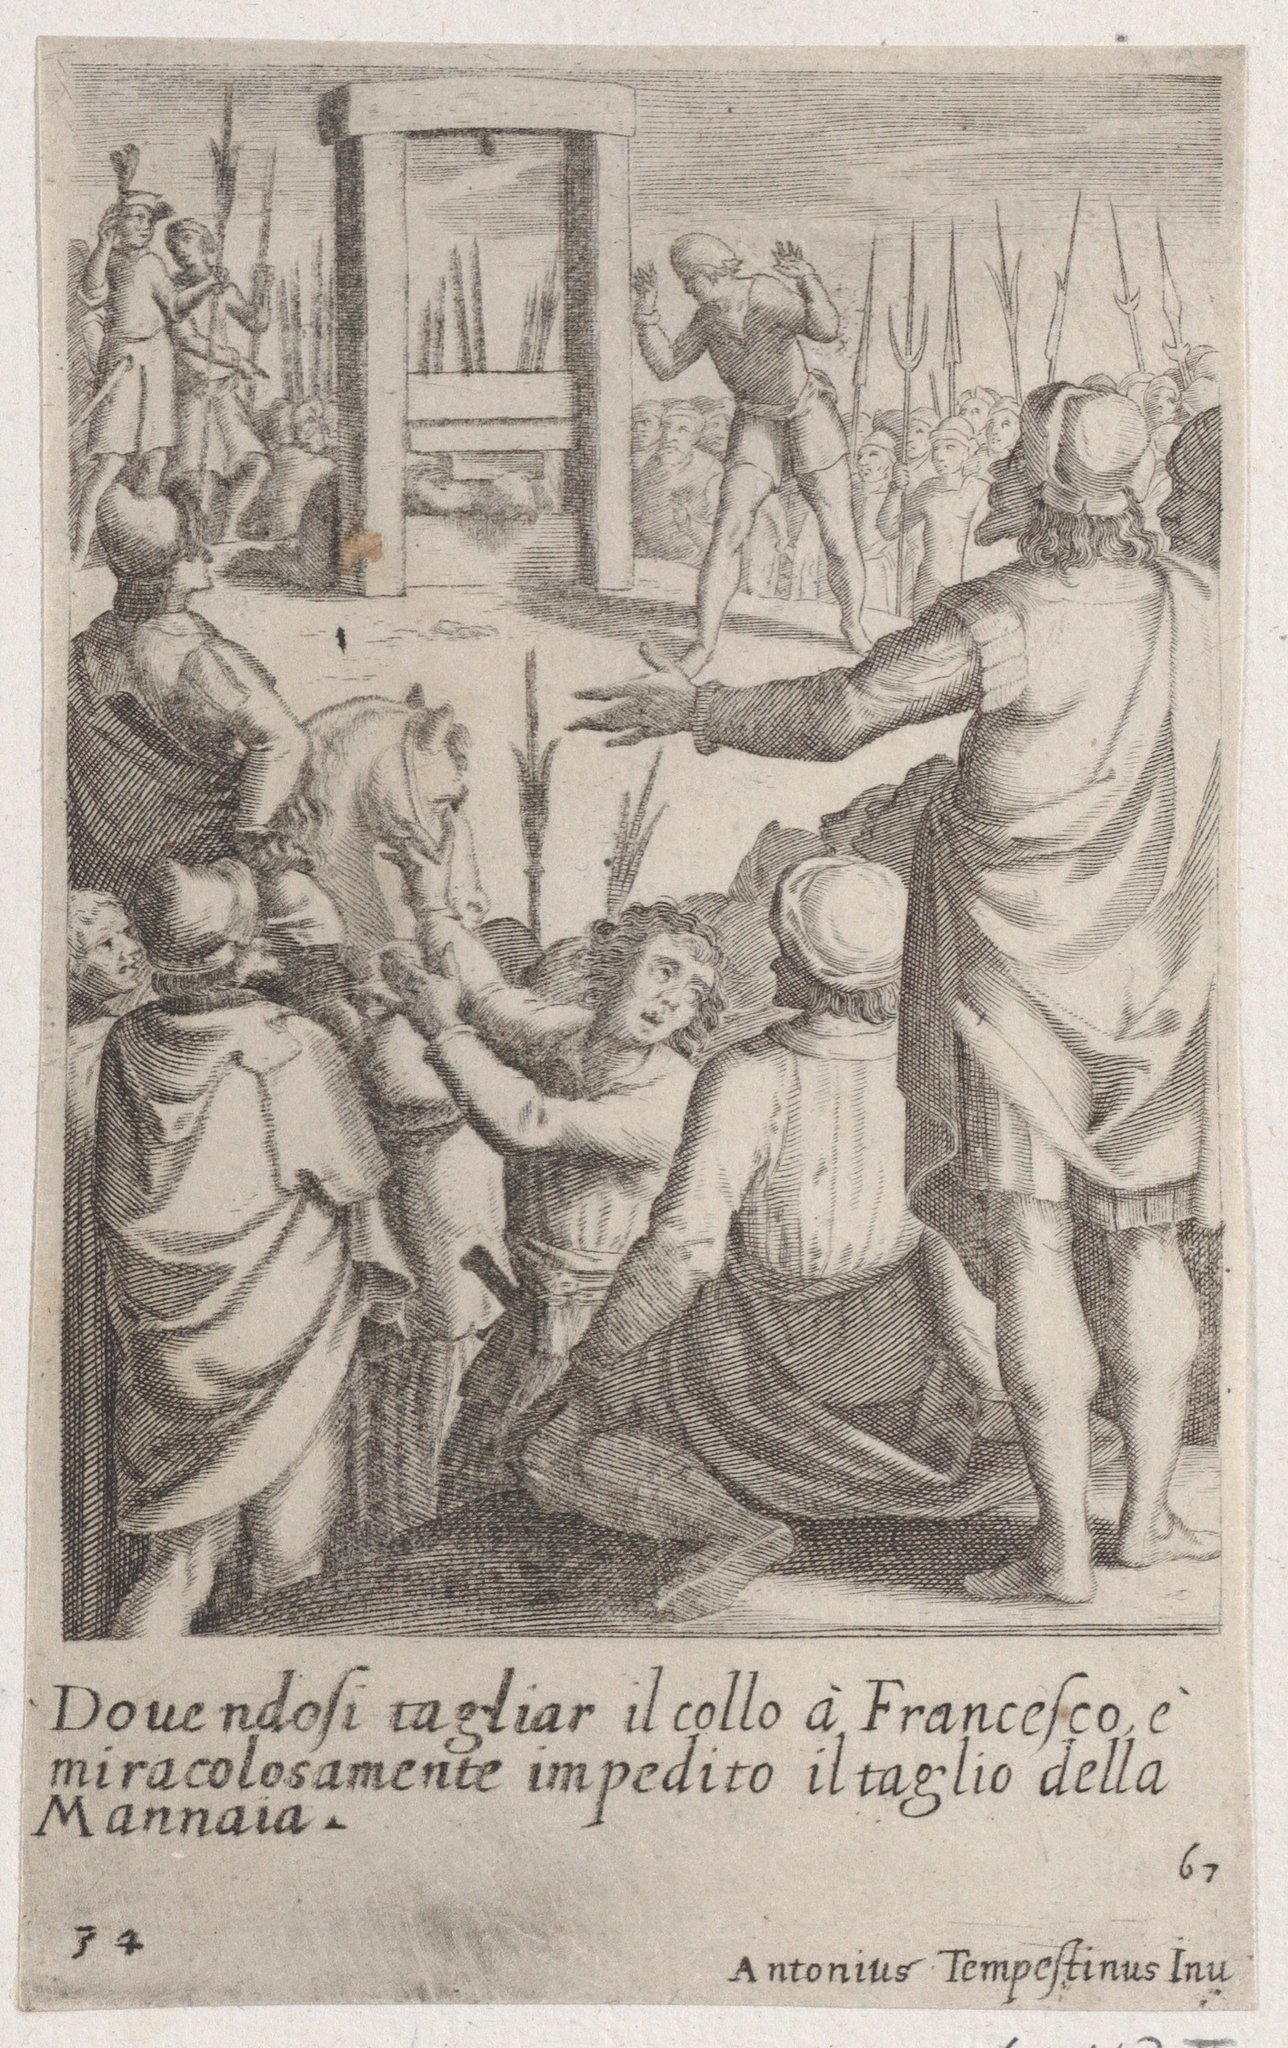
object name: print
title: Francesco, from Scelta d'Alcuni Miracoli e Grazie della Santissima Nunziata di Firenze (Selection of Some Miracles and Graces that Occurred in the Church of the Annunziata in Florence)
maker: jacques callot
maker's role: artist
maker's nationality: french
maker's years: 1592-1635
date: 1611-1619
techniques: engraving